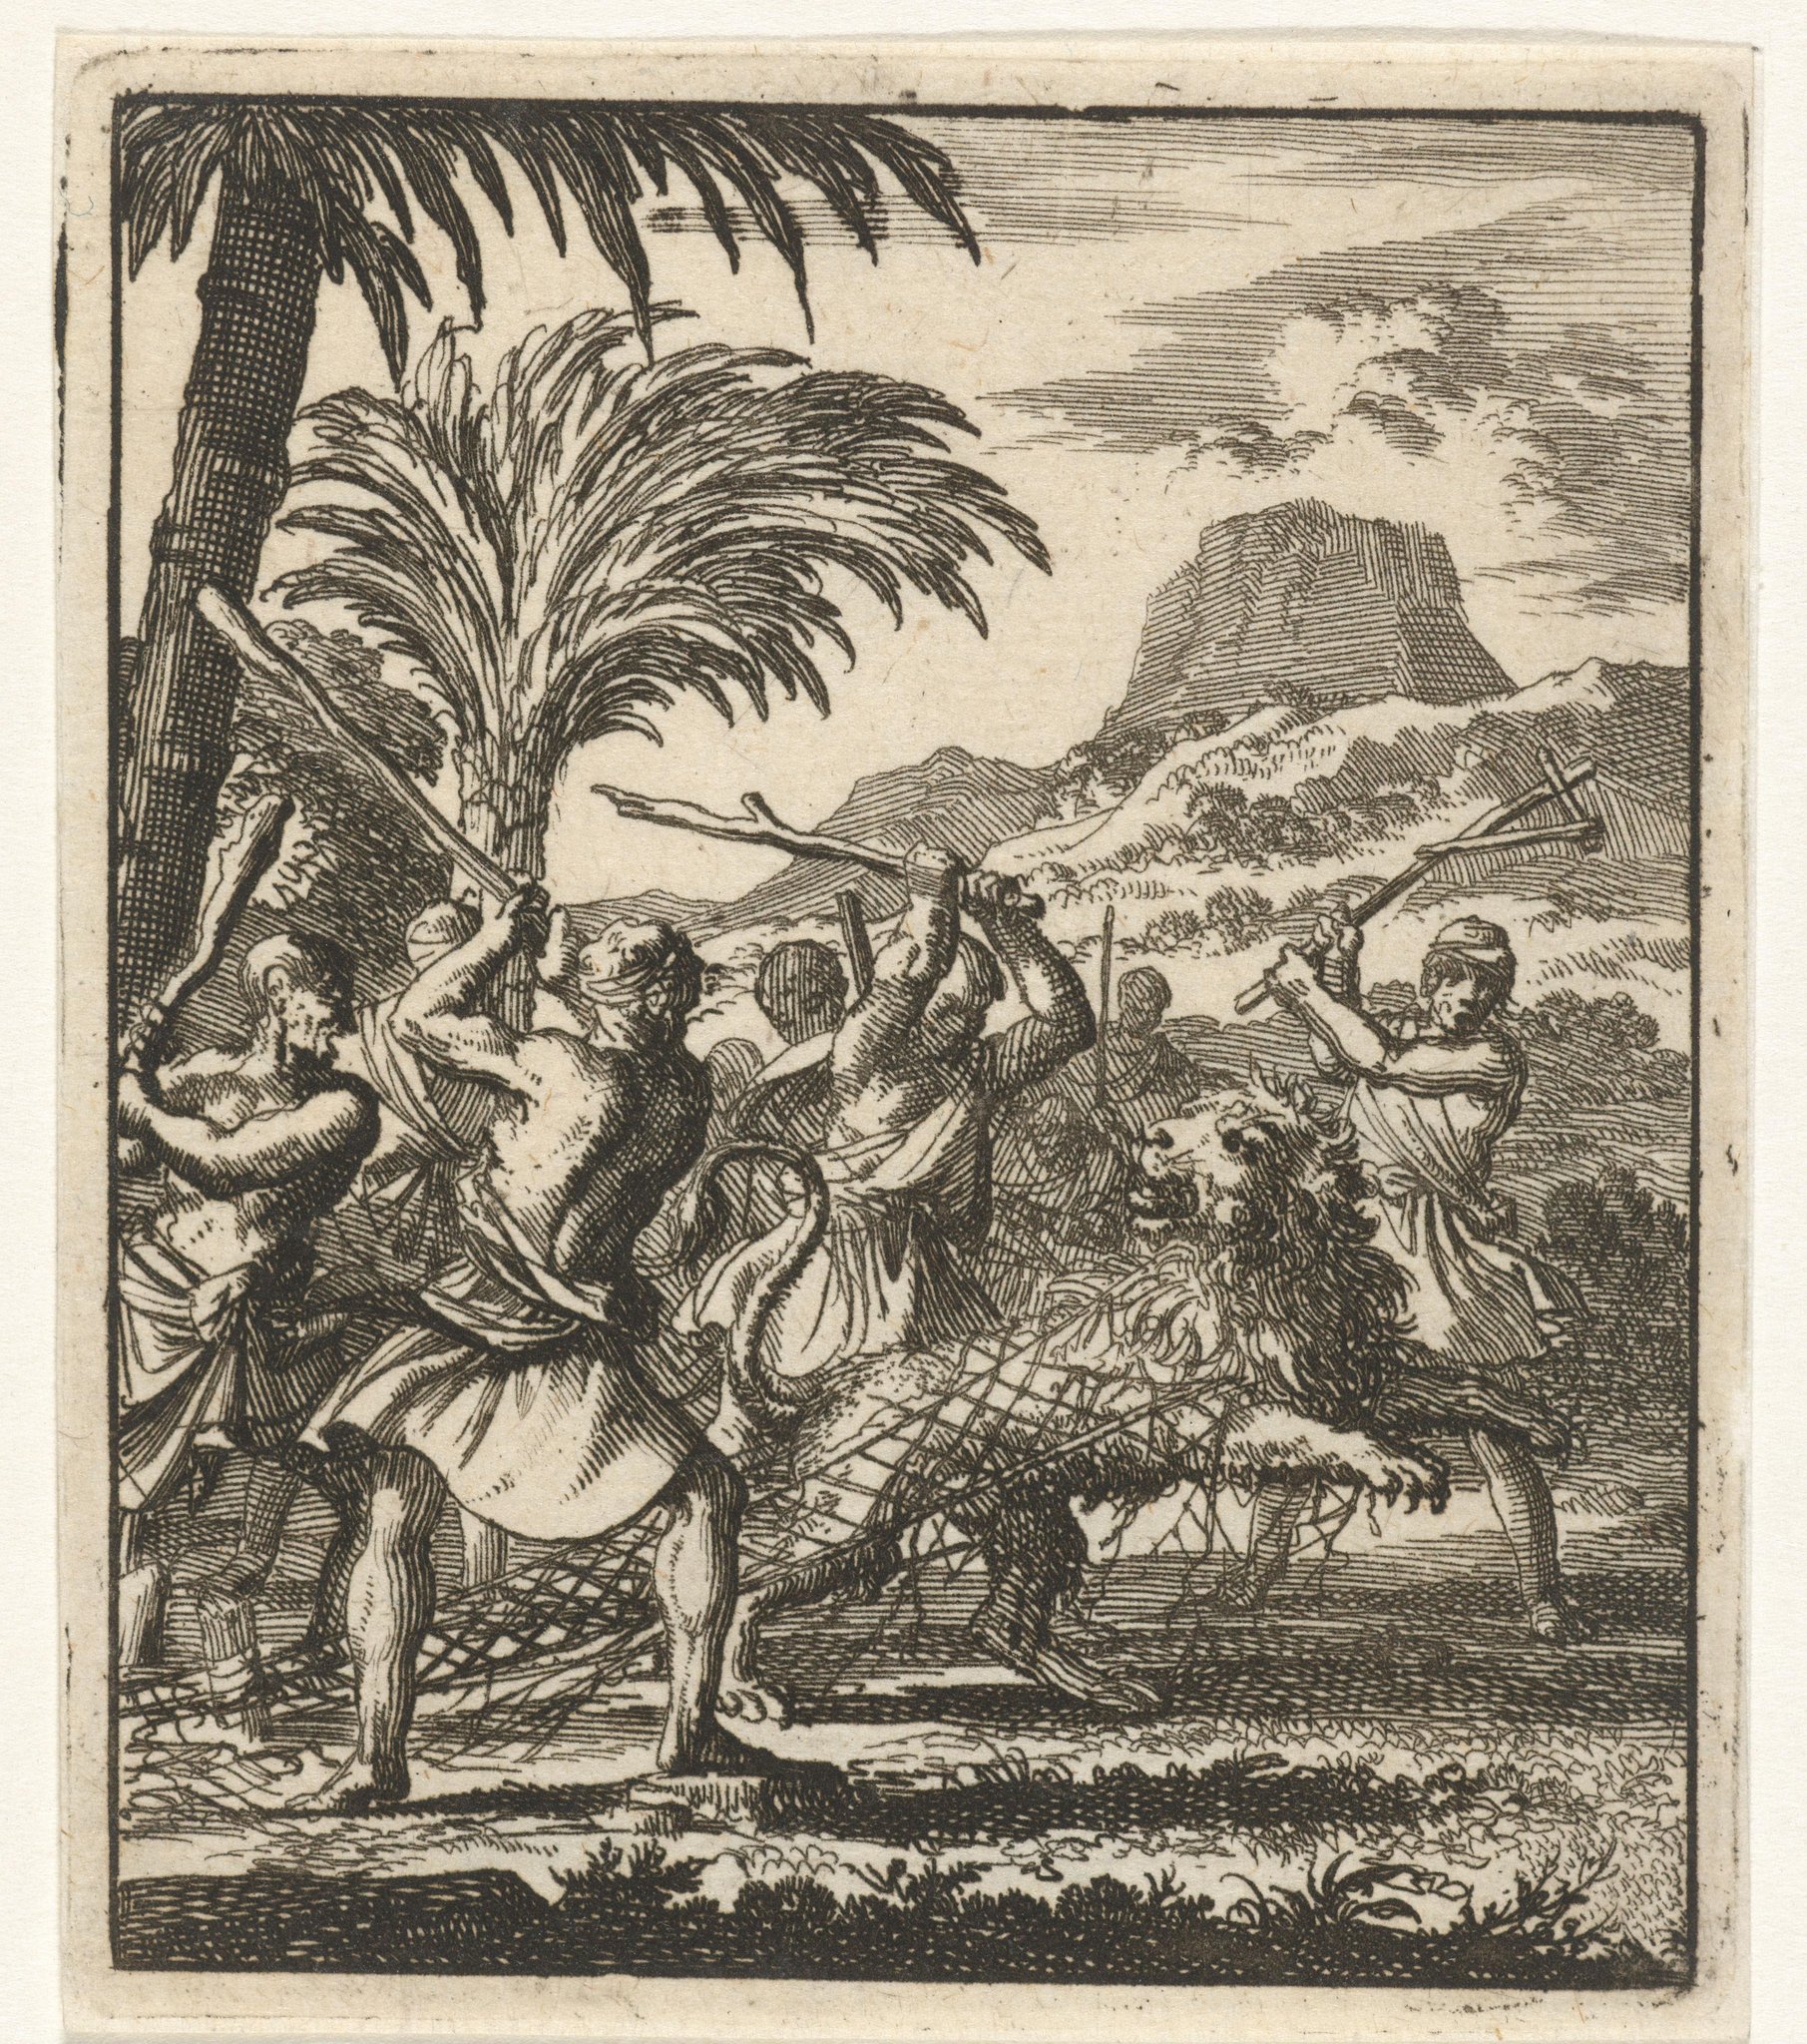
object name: book illustration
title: In een net gevangen leeuw door vier mannen met stokken geslagen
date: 1693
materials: paper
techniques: etching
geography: amsterdam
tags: hunter fighting a lion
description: Illustratie uit: Duĳkerius, Johannes. Voorbeeldzels der oude wyzen. Waar in (...) de menschelijke hartstogten (...) behandeld worden. Amsterdam: Aart Wolsgrein, 1693, p. 563.